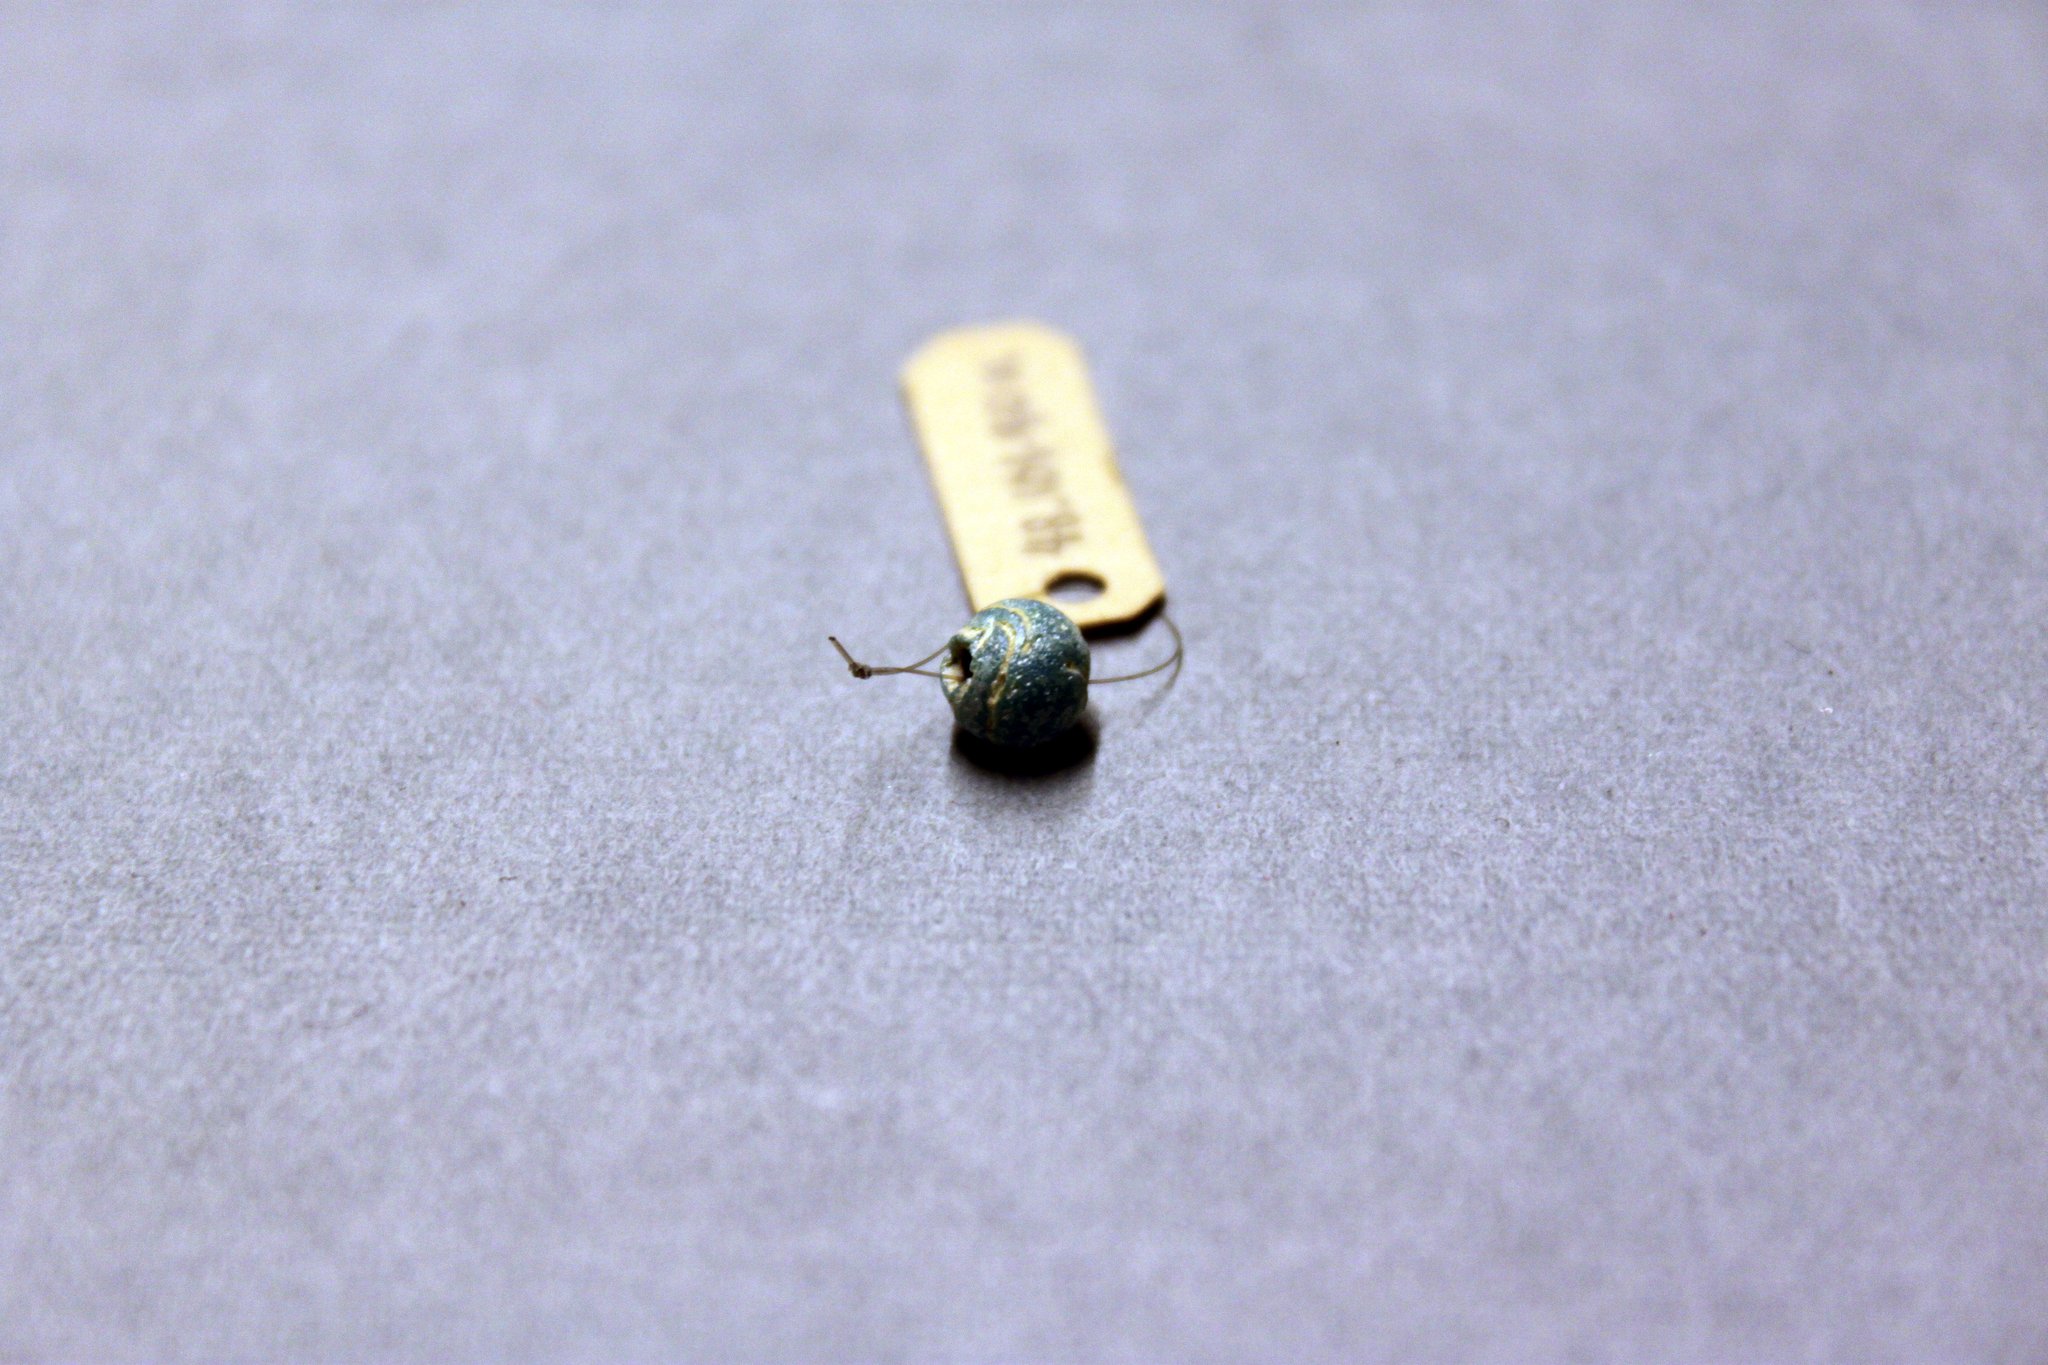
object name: bead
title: Beads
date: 701-1300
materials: glass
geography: iran